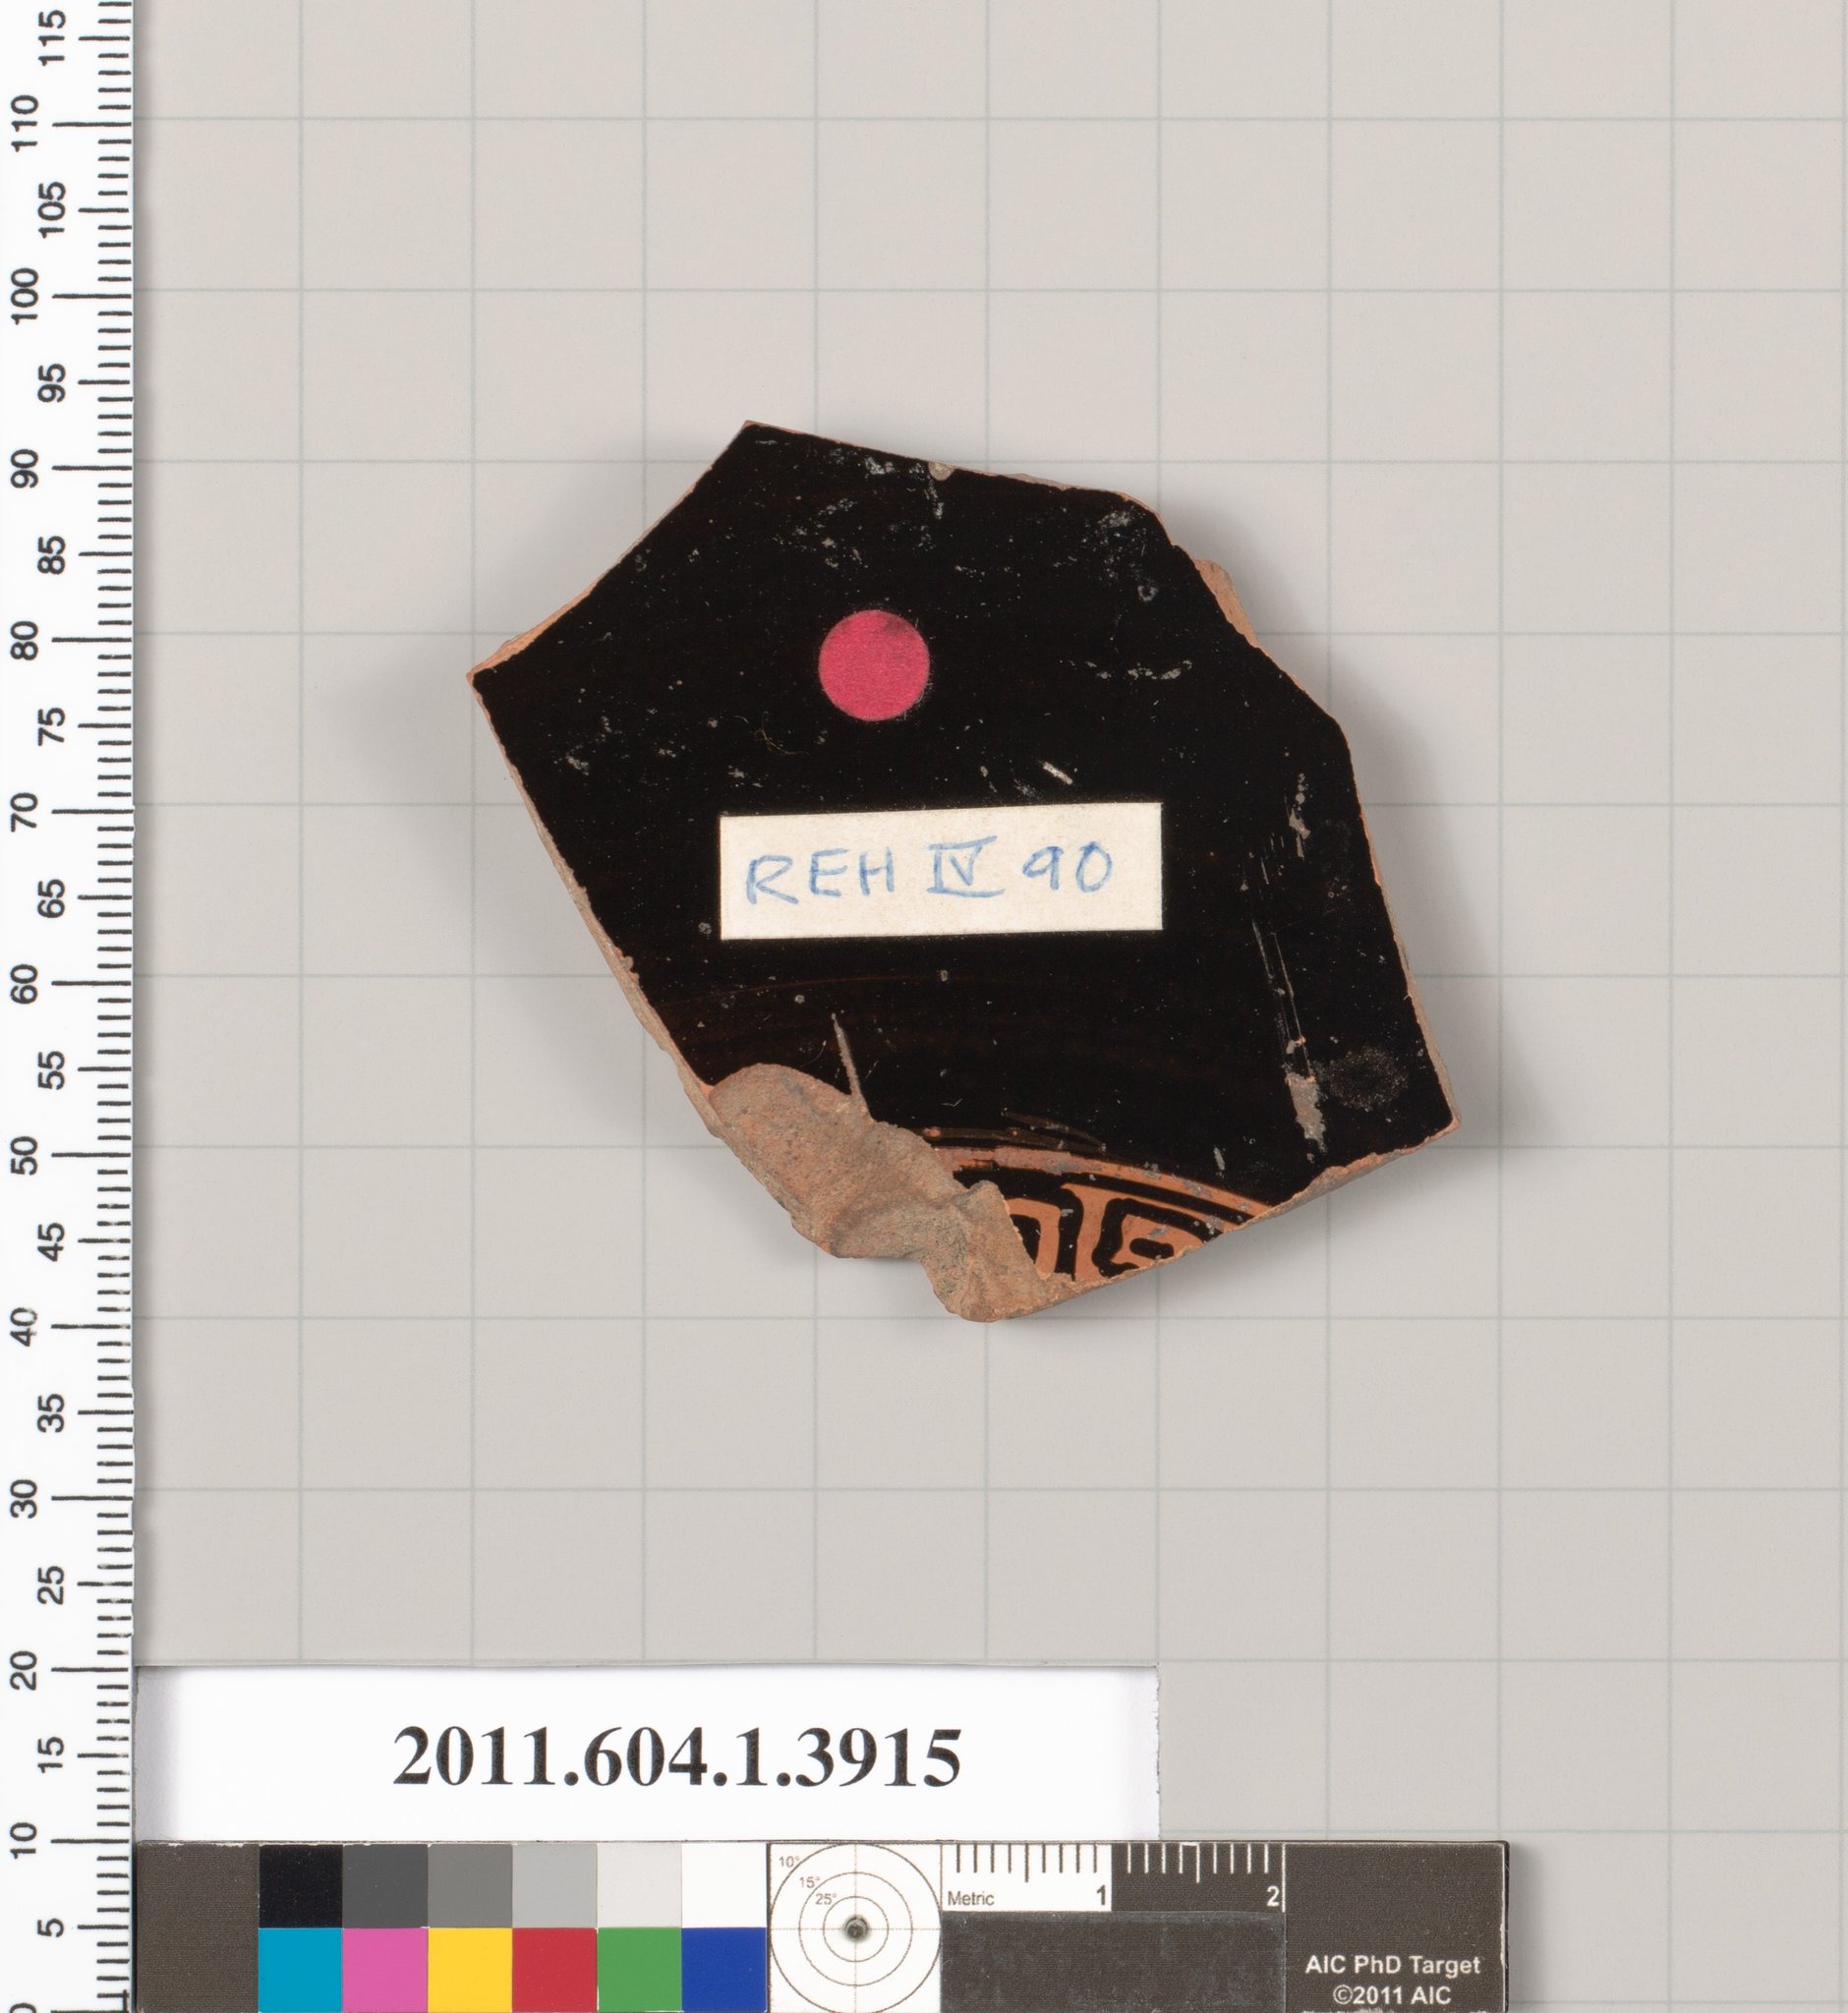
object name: kylix fragment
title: Terracotta fragment of a kylix (drinking cup)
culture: greek, attic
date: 490-470 BCE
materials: terracotta